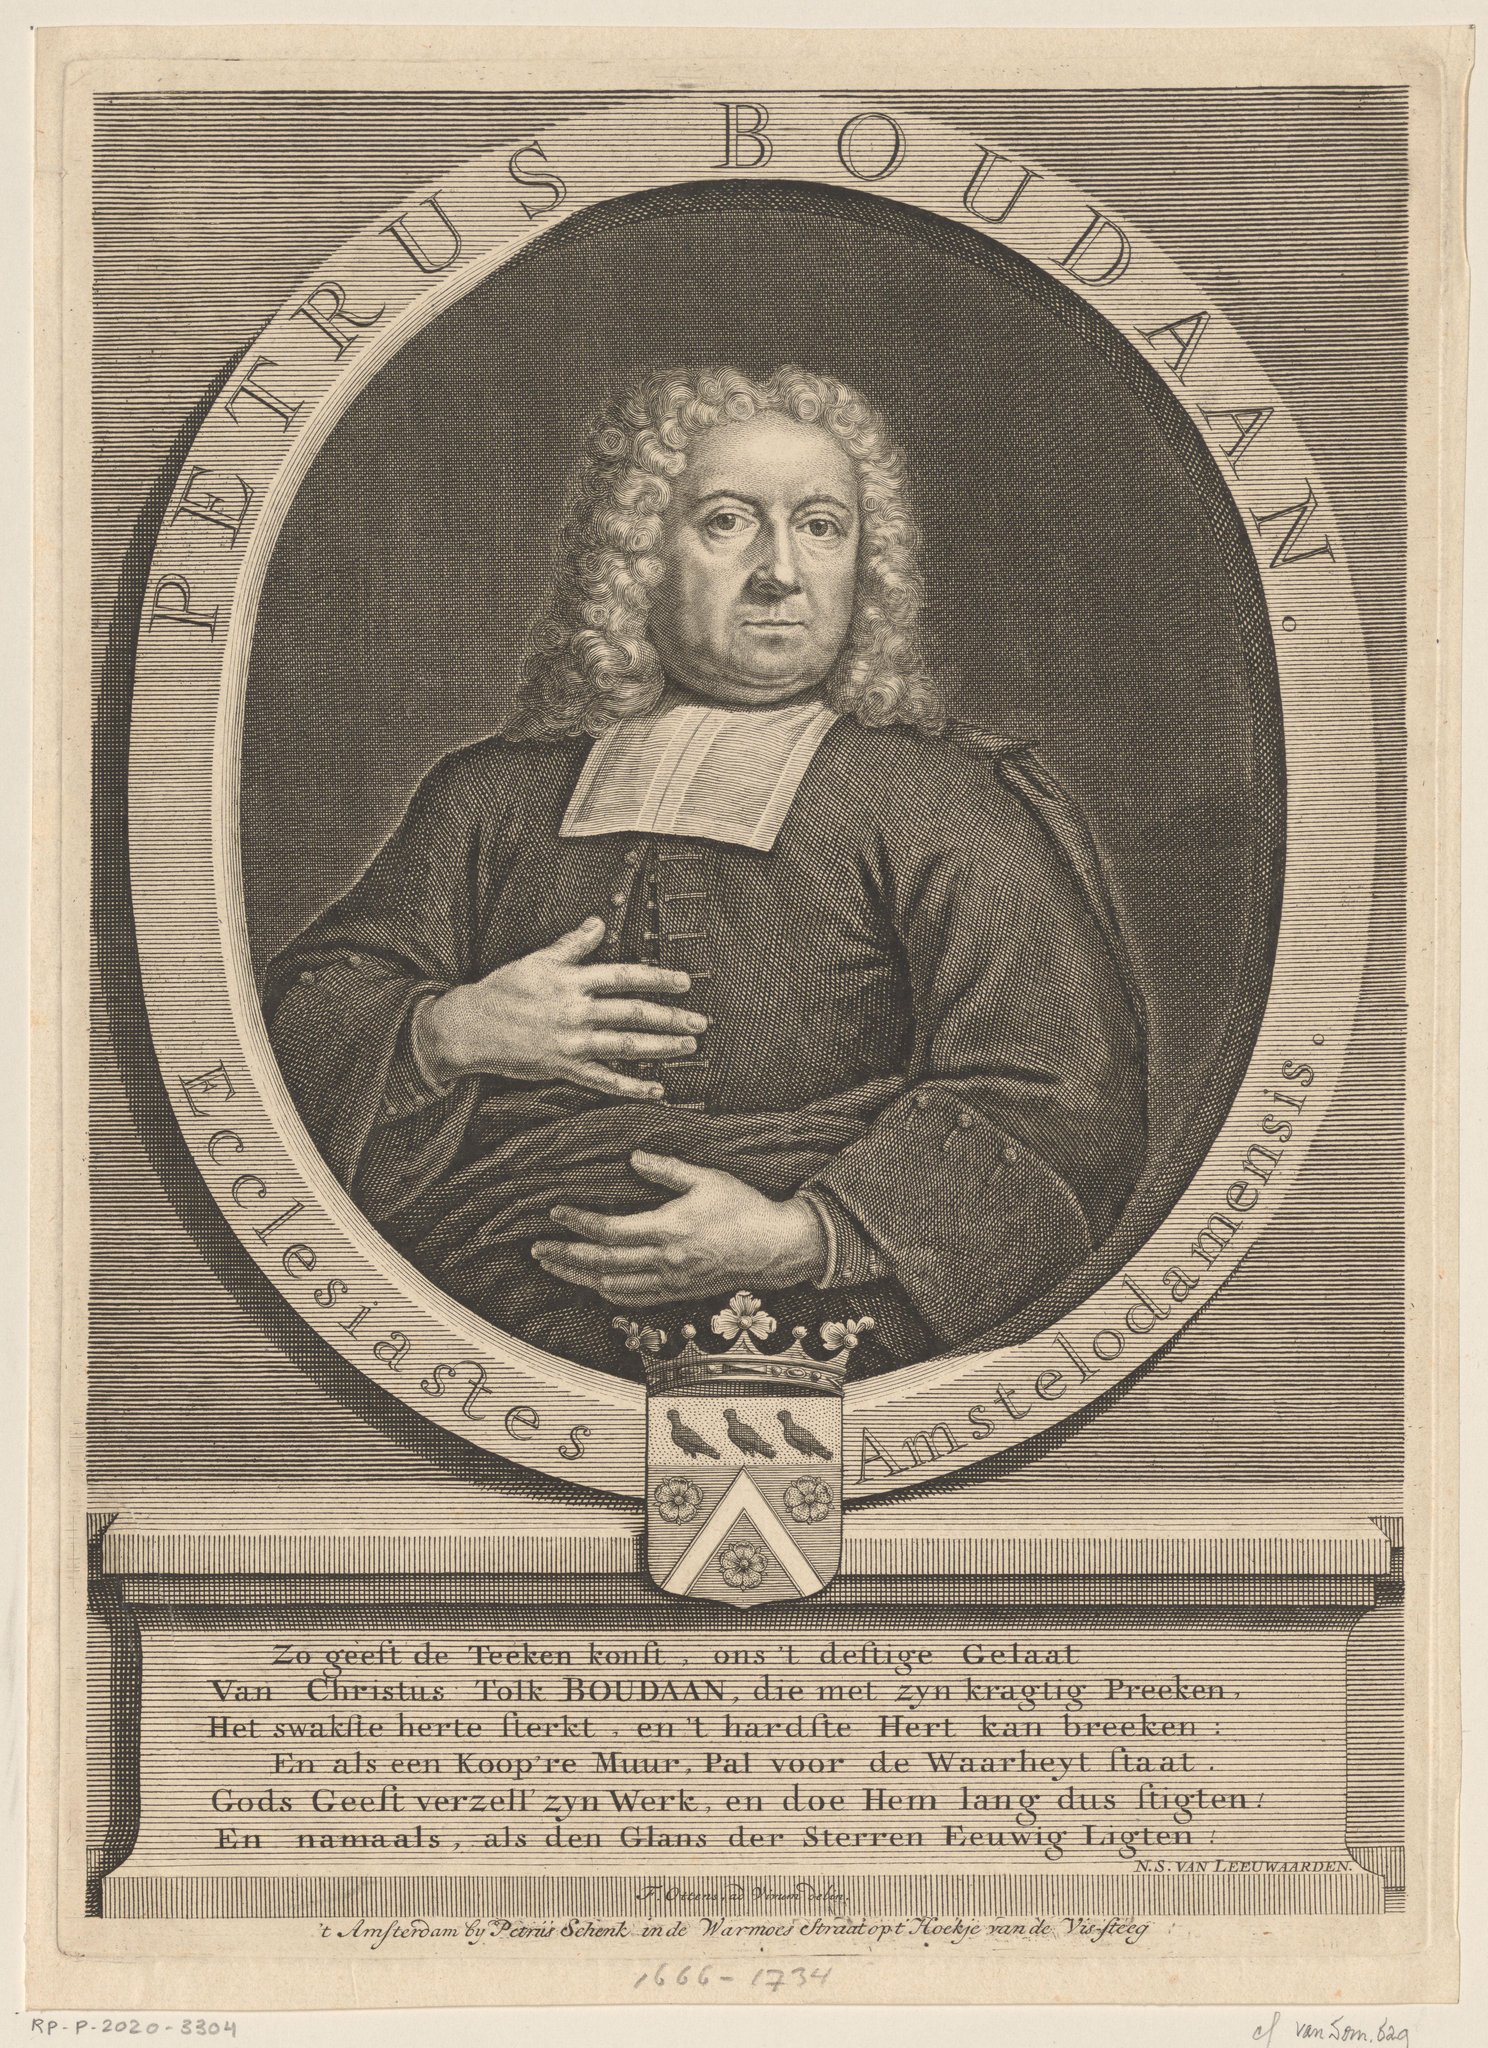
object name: print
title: Portret van Petrus Boudaan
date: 1728-1738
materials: paper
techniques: engraving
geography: amsterdam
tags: historical persons, armorial bearing, heraldry